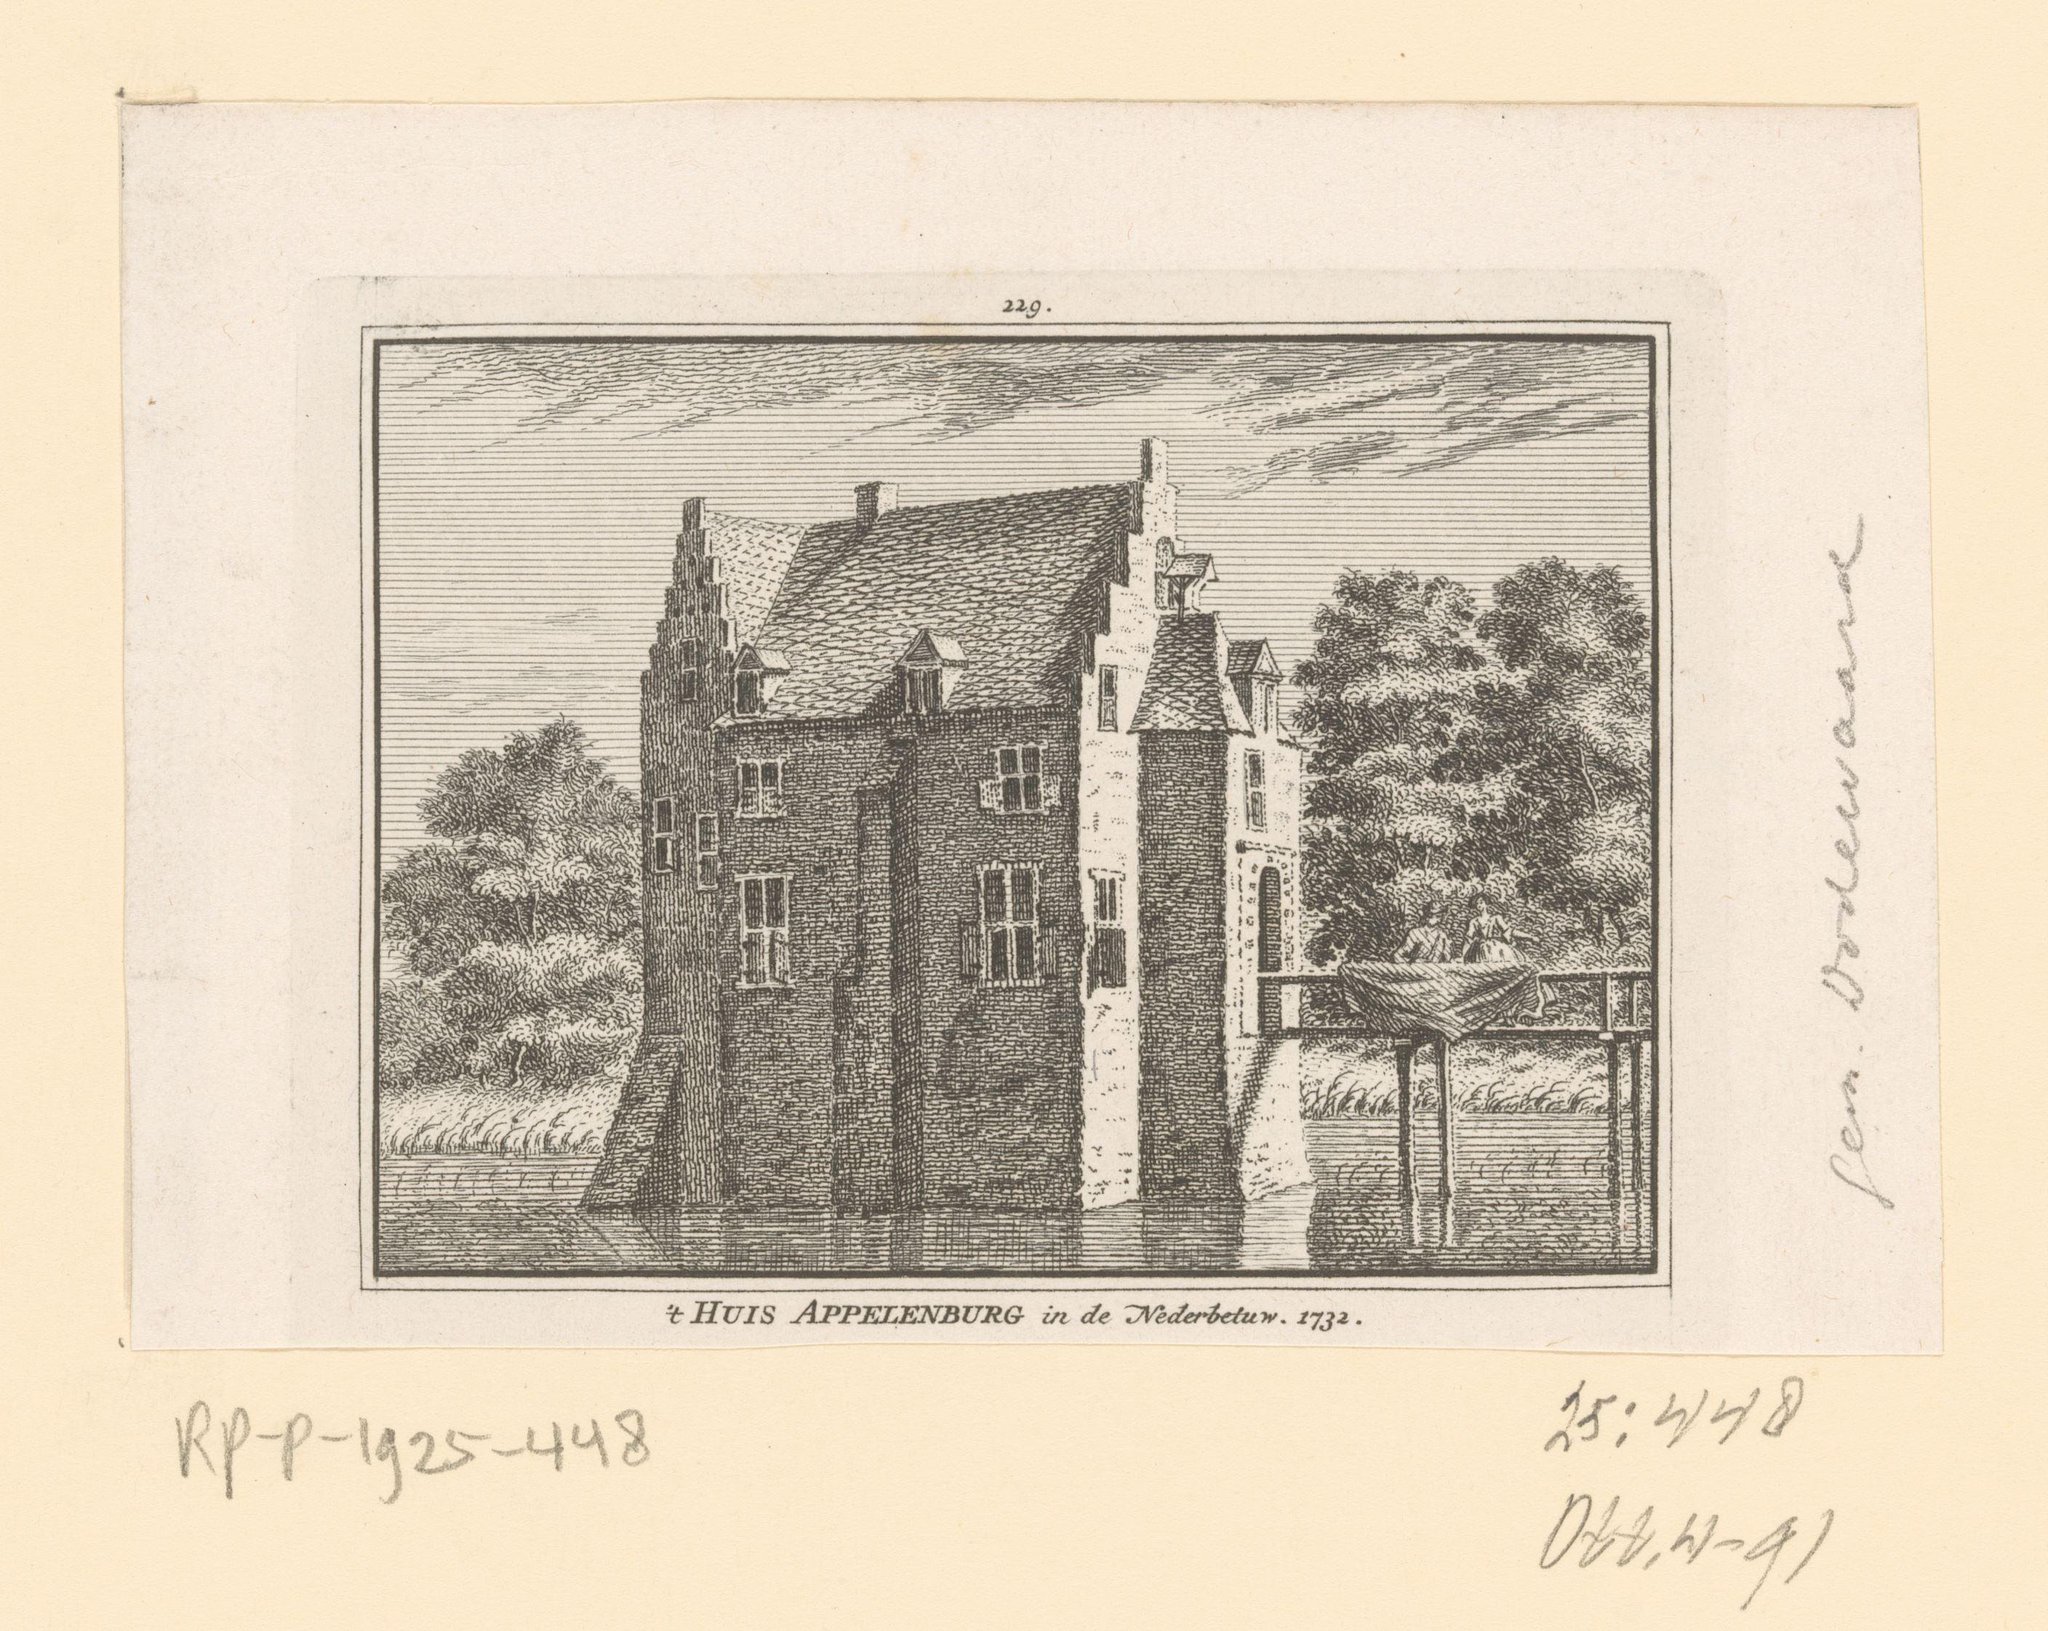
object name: print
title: 't Huis Appelenburg in de Nederbetuw, 1732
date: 1750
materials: paper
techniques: etching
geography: amsterdam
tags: castle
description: Prent uit: Het verheerlykt Nederland of Kabinet van Hedendaagsche Gezigten (...). Amsterdam: Isaak Tirion, 1750, dl. 3.